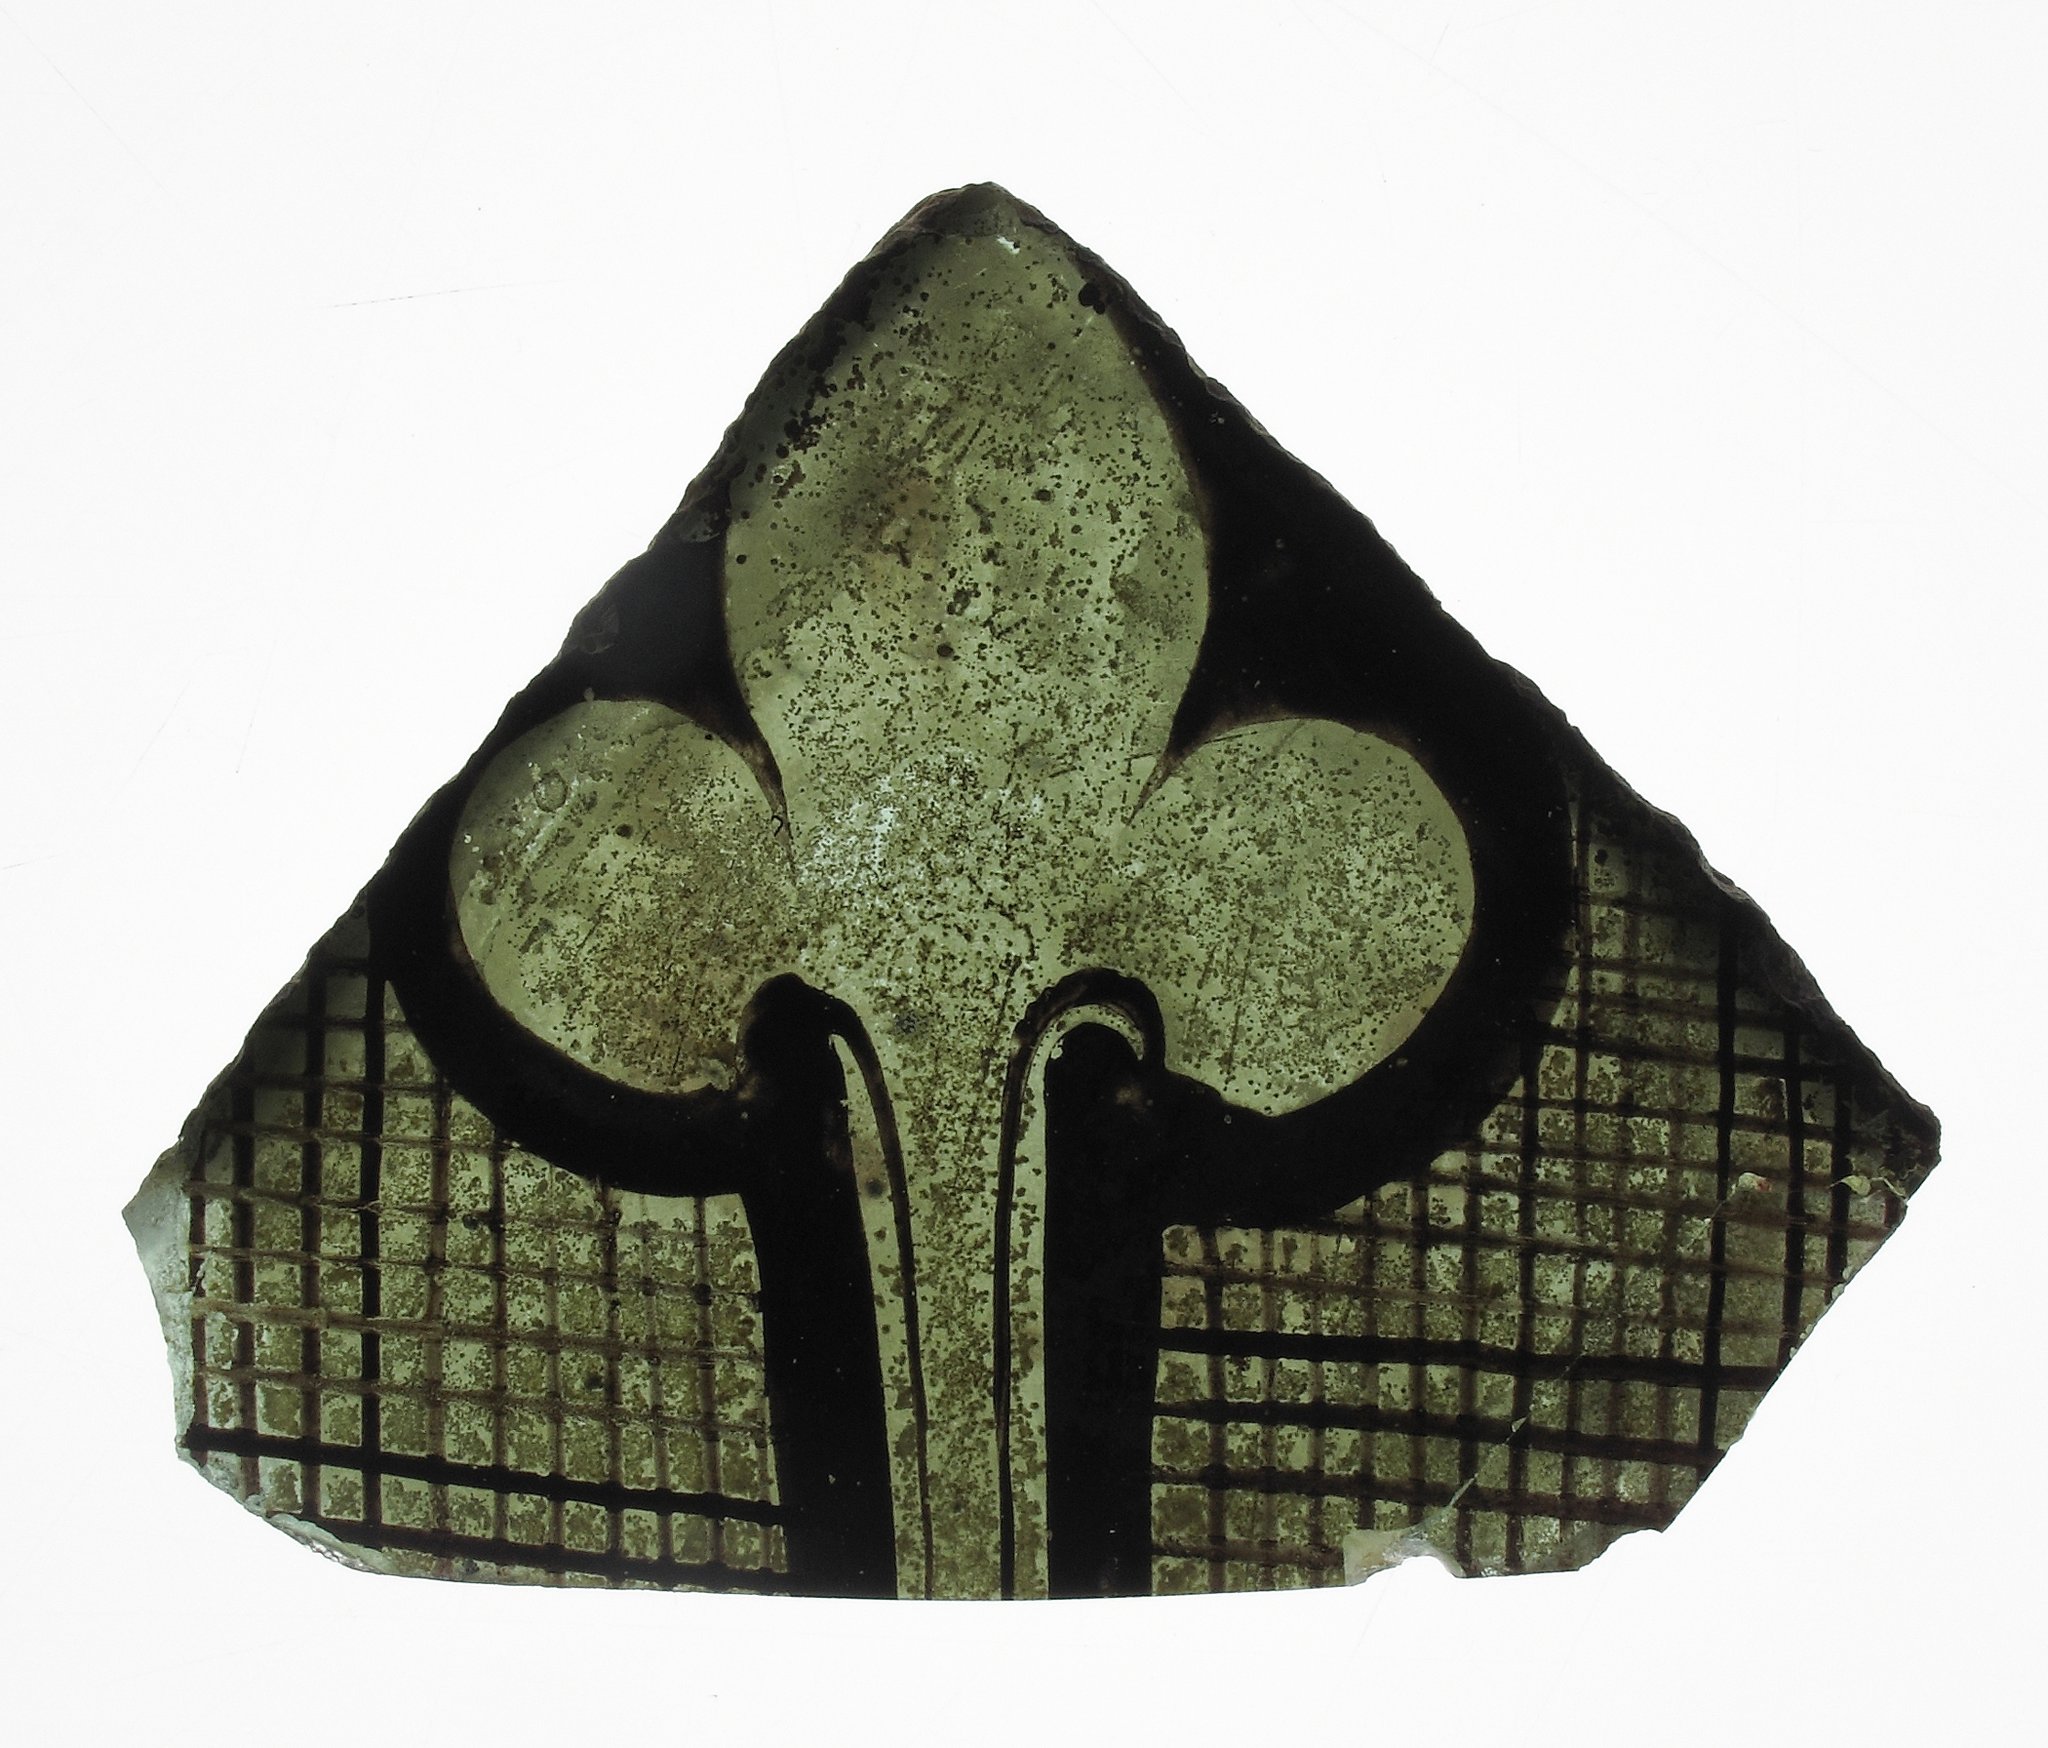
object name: fragment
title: Glass Fragment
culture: british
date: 1290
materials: glass